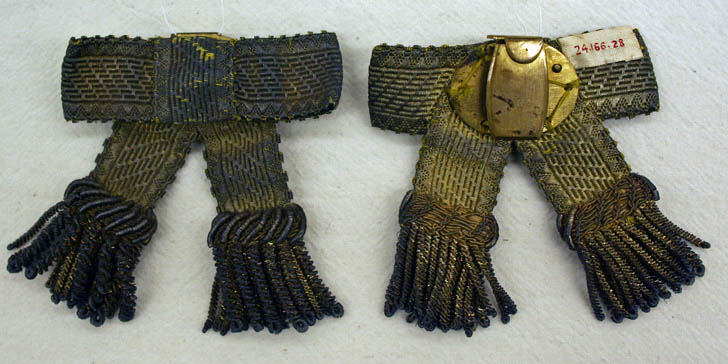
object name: garter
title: Garters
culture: french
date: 1801-1833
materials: metal thread